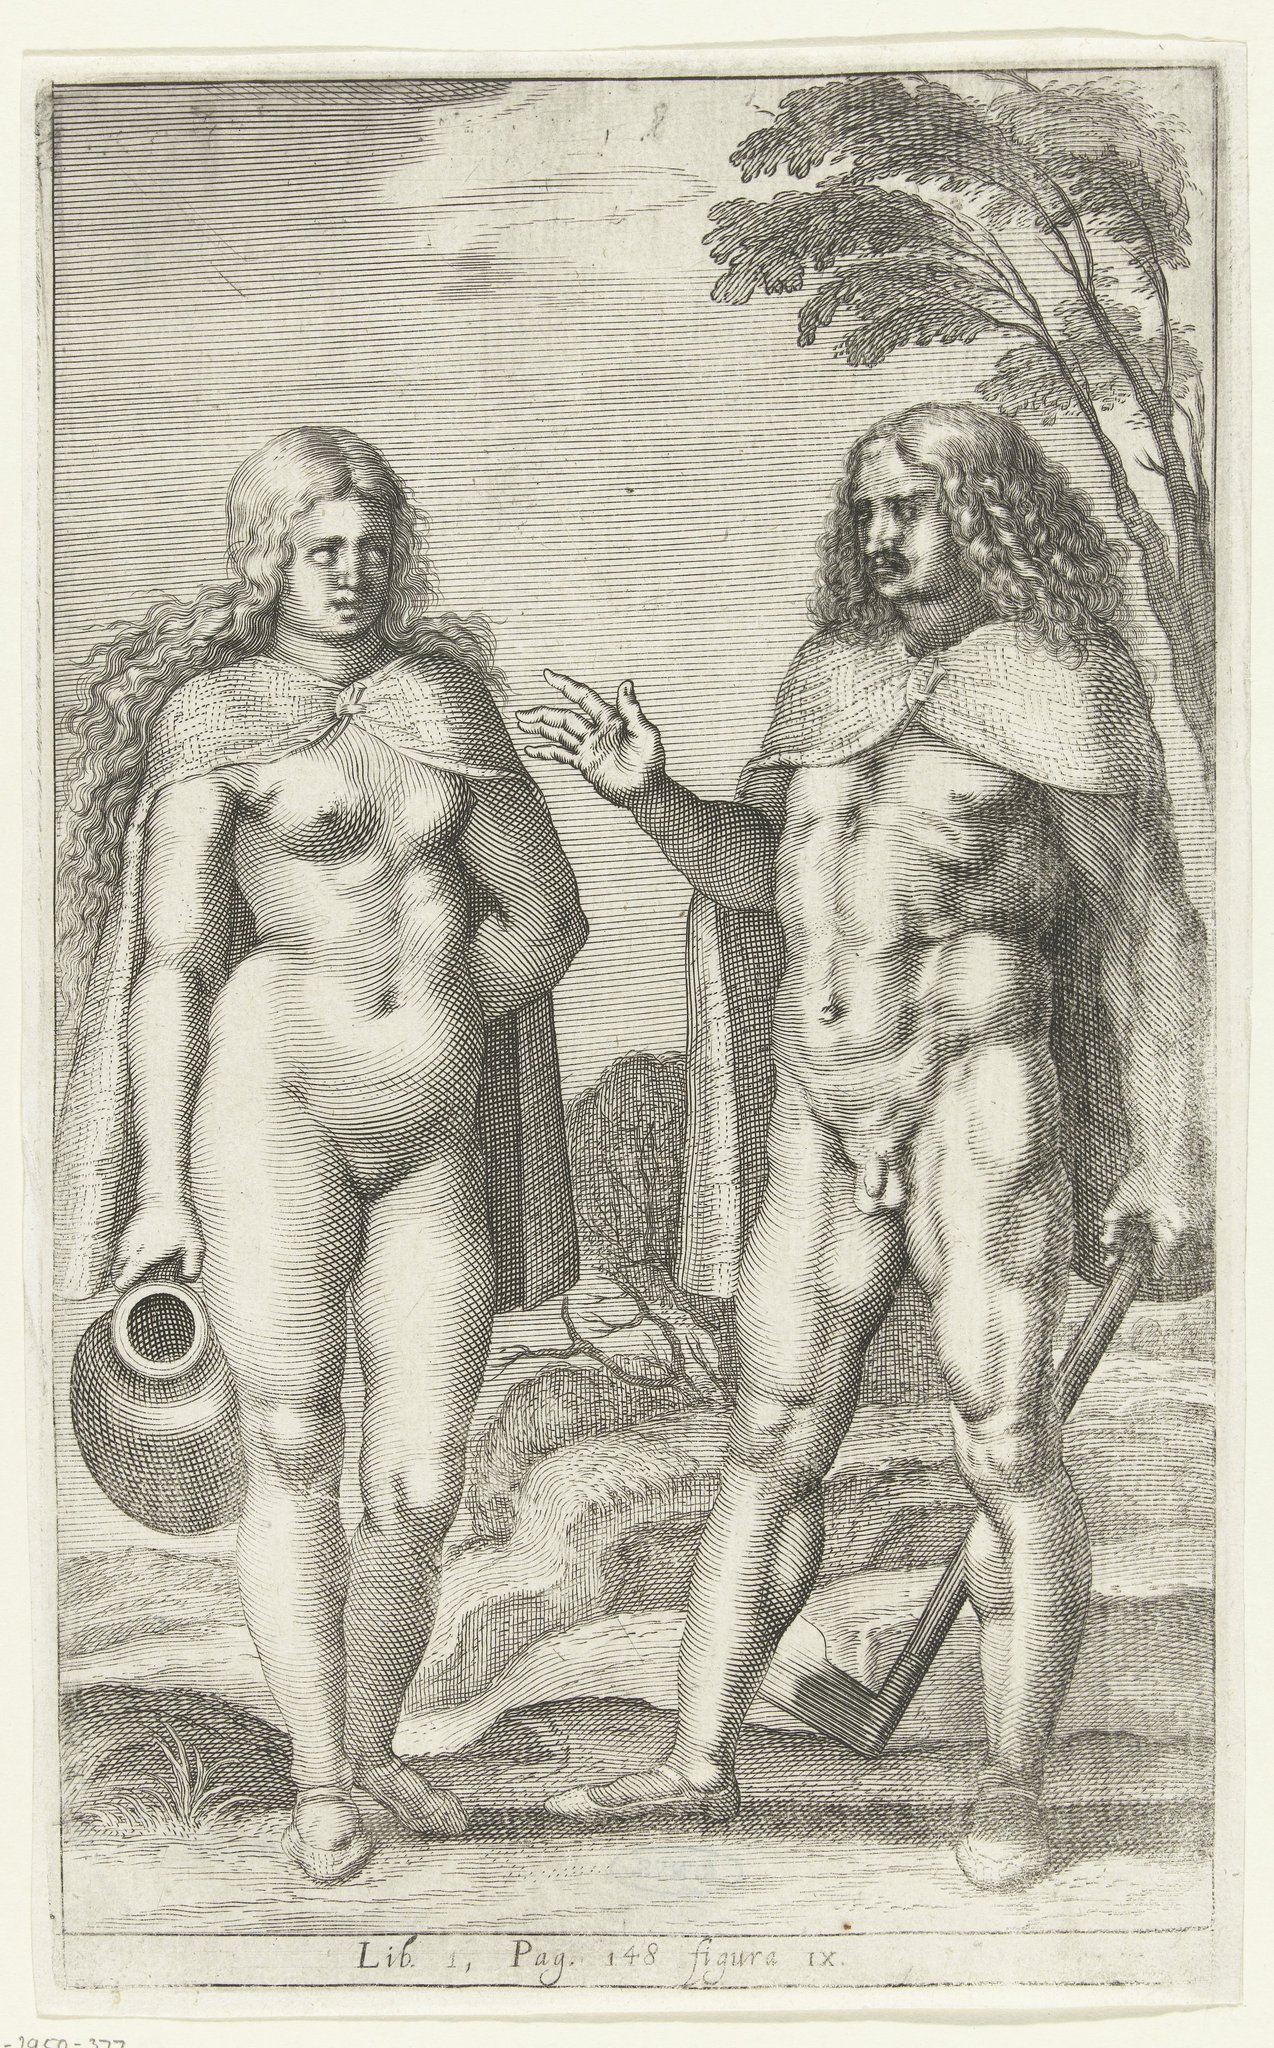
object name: print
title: Germaanse man en vrouw, figura IX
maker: Anonymous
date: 1614-1616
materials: paper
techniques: engraving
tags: extinct, 'historical' peoples (with name)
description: voor Cluverius Germ. Ant. Niet in Frederik Muller; door het RPK toegevoegd nummer. Prenten RP-P-1950-364, 377 en 378 zijn door een andere hand gegraveerd, terwijl de rest van de serie geëtst is.